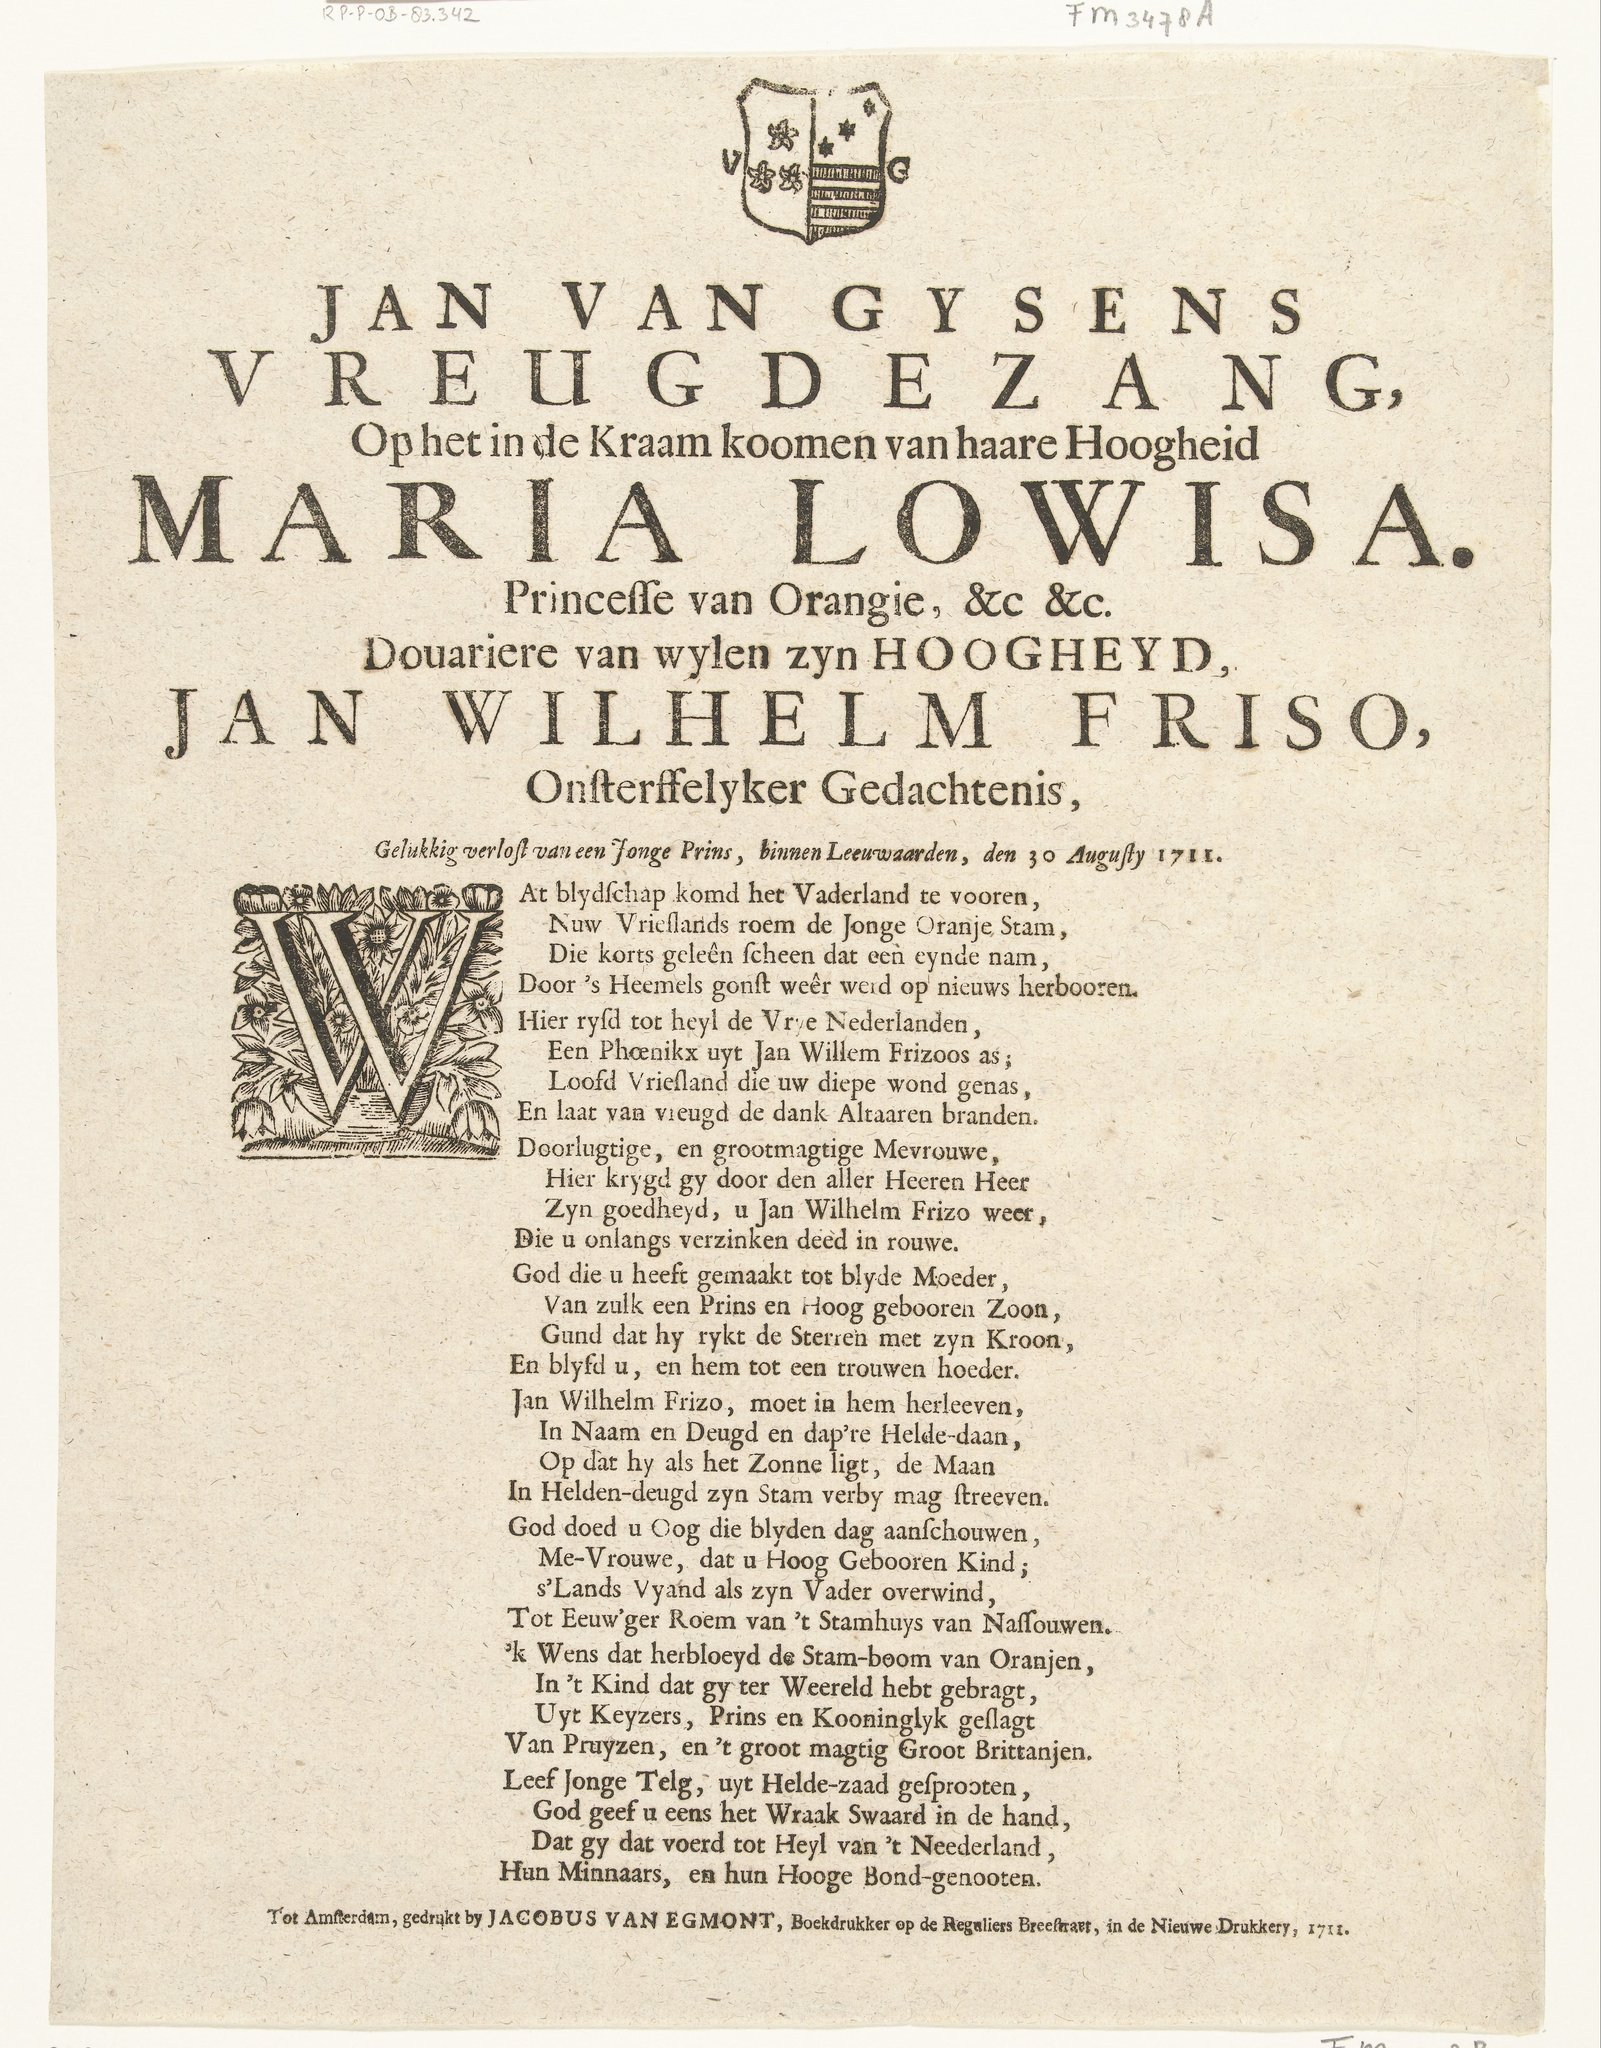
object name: text sheet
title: Vreugdezang op de geboorte van de prins, 1711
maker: jacobus van egmont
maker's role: printer, publisher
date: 1711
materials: paper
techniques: letterpress printing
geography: amsterdam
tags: the hague, willem iv (prins van oranje-nassau)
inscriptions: date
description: Blad met de tekst van een vreugdezang gecomponeerd ter gelegenheid van de geboorte te Leeuwarden van de prins Willem Karel Hendrik Friso (de latere erfstadhouder Willem IV) op 1 september 1711.